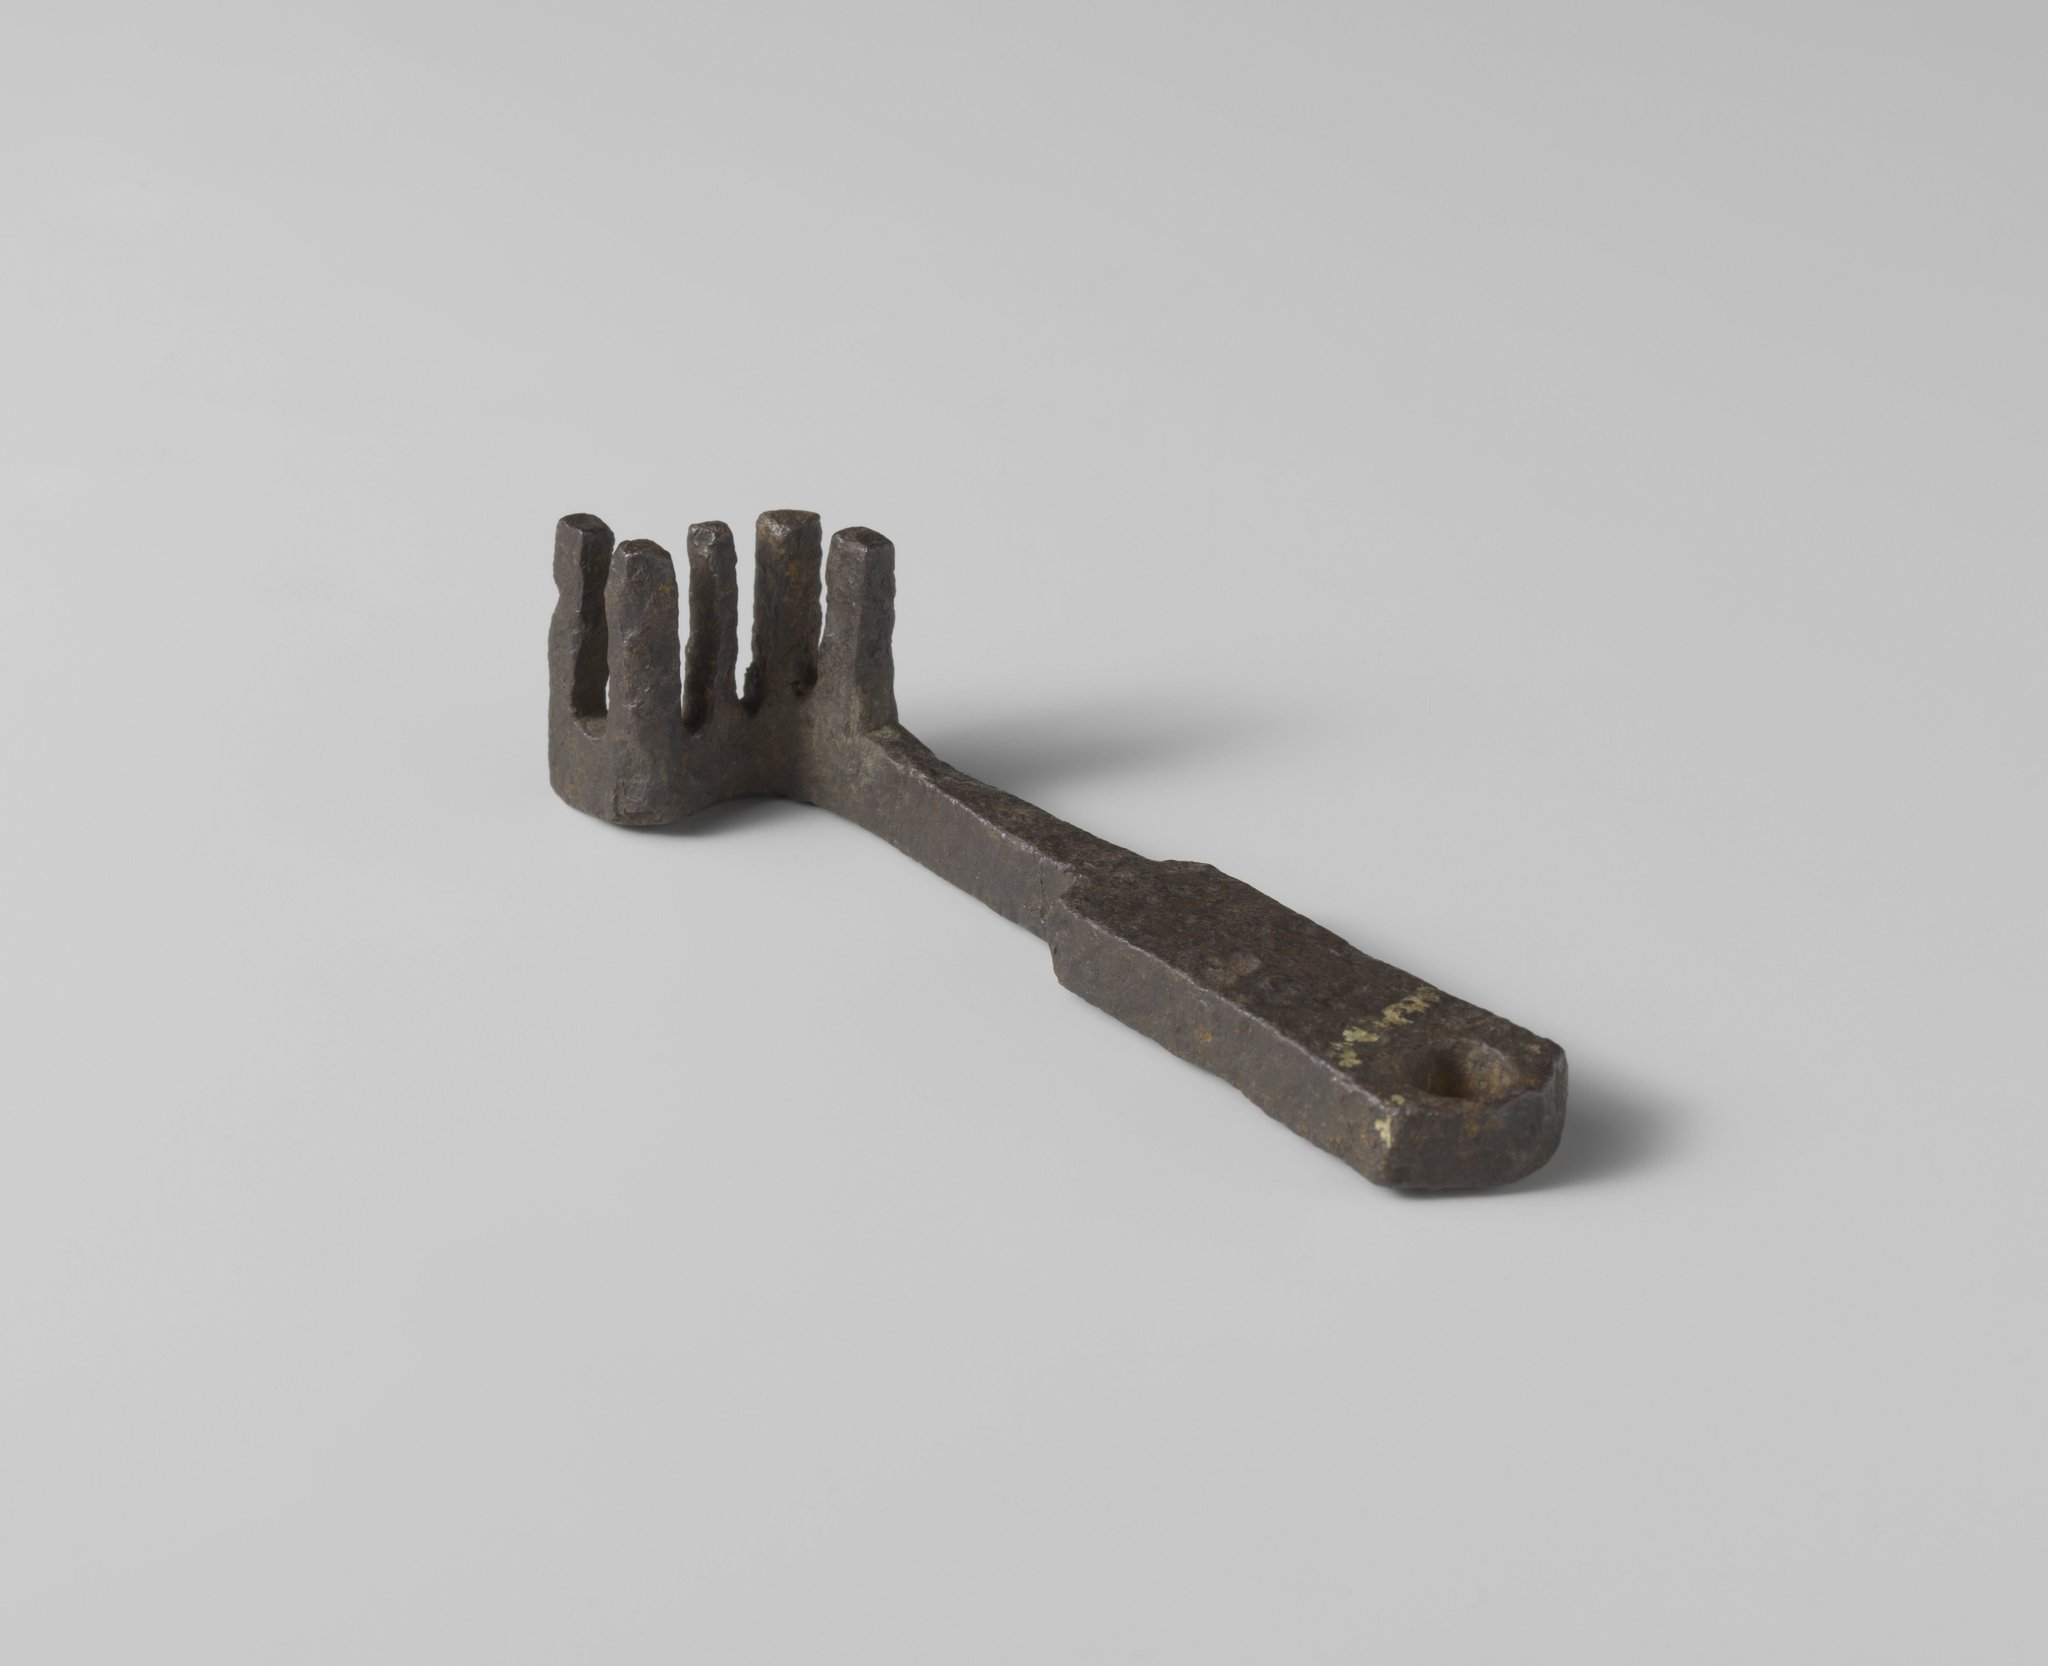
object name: hefsleutel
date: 1400-1950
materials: iron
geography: rome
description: Hefsleutel met greep bestaande uit een verbreding van de steel met bovenin een oog. Aan de vierzijdige steel bevindt zich de door verwisselende binnenhoeken gevormde baard met vijf tanden.